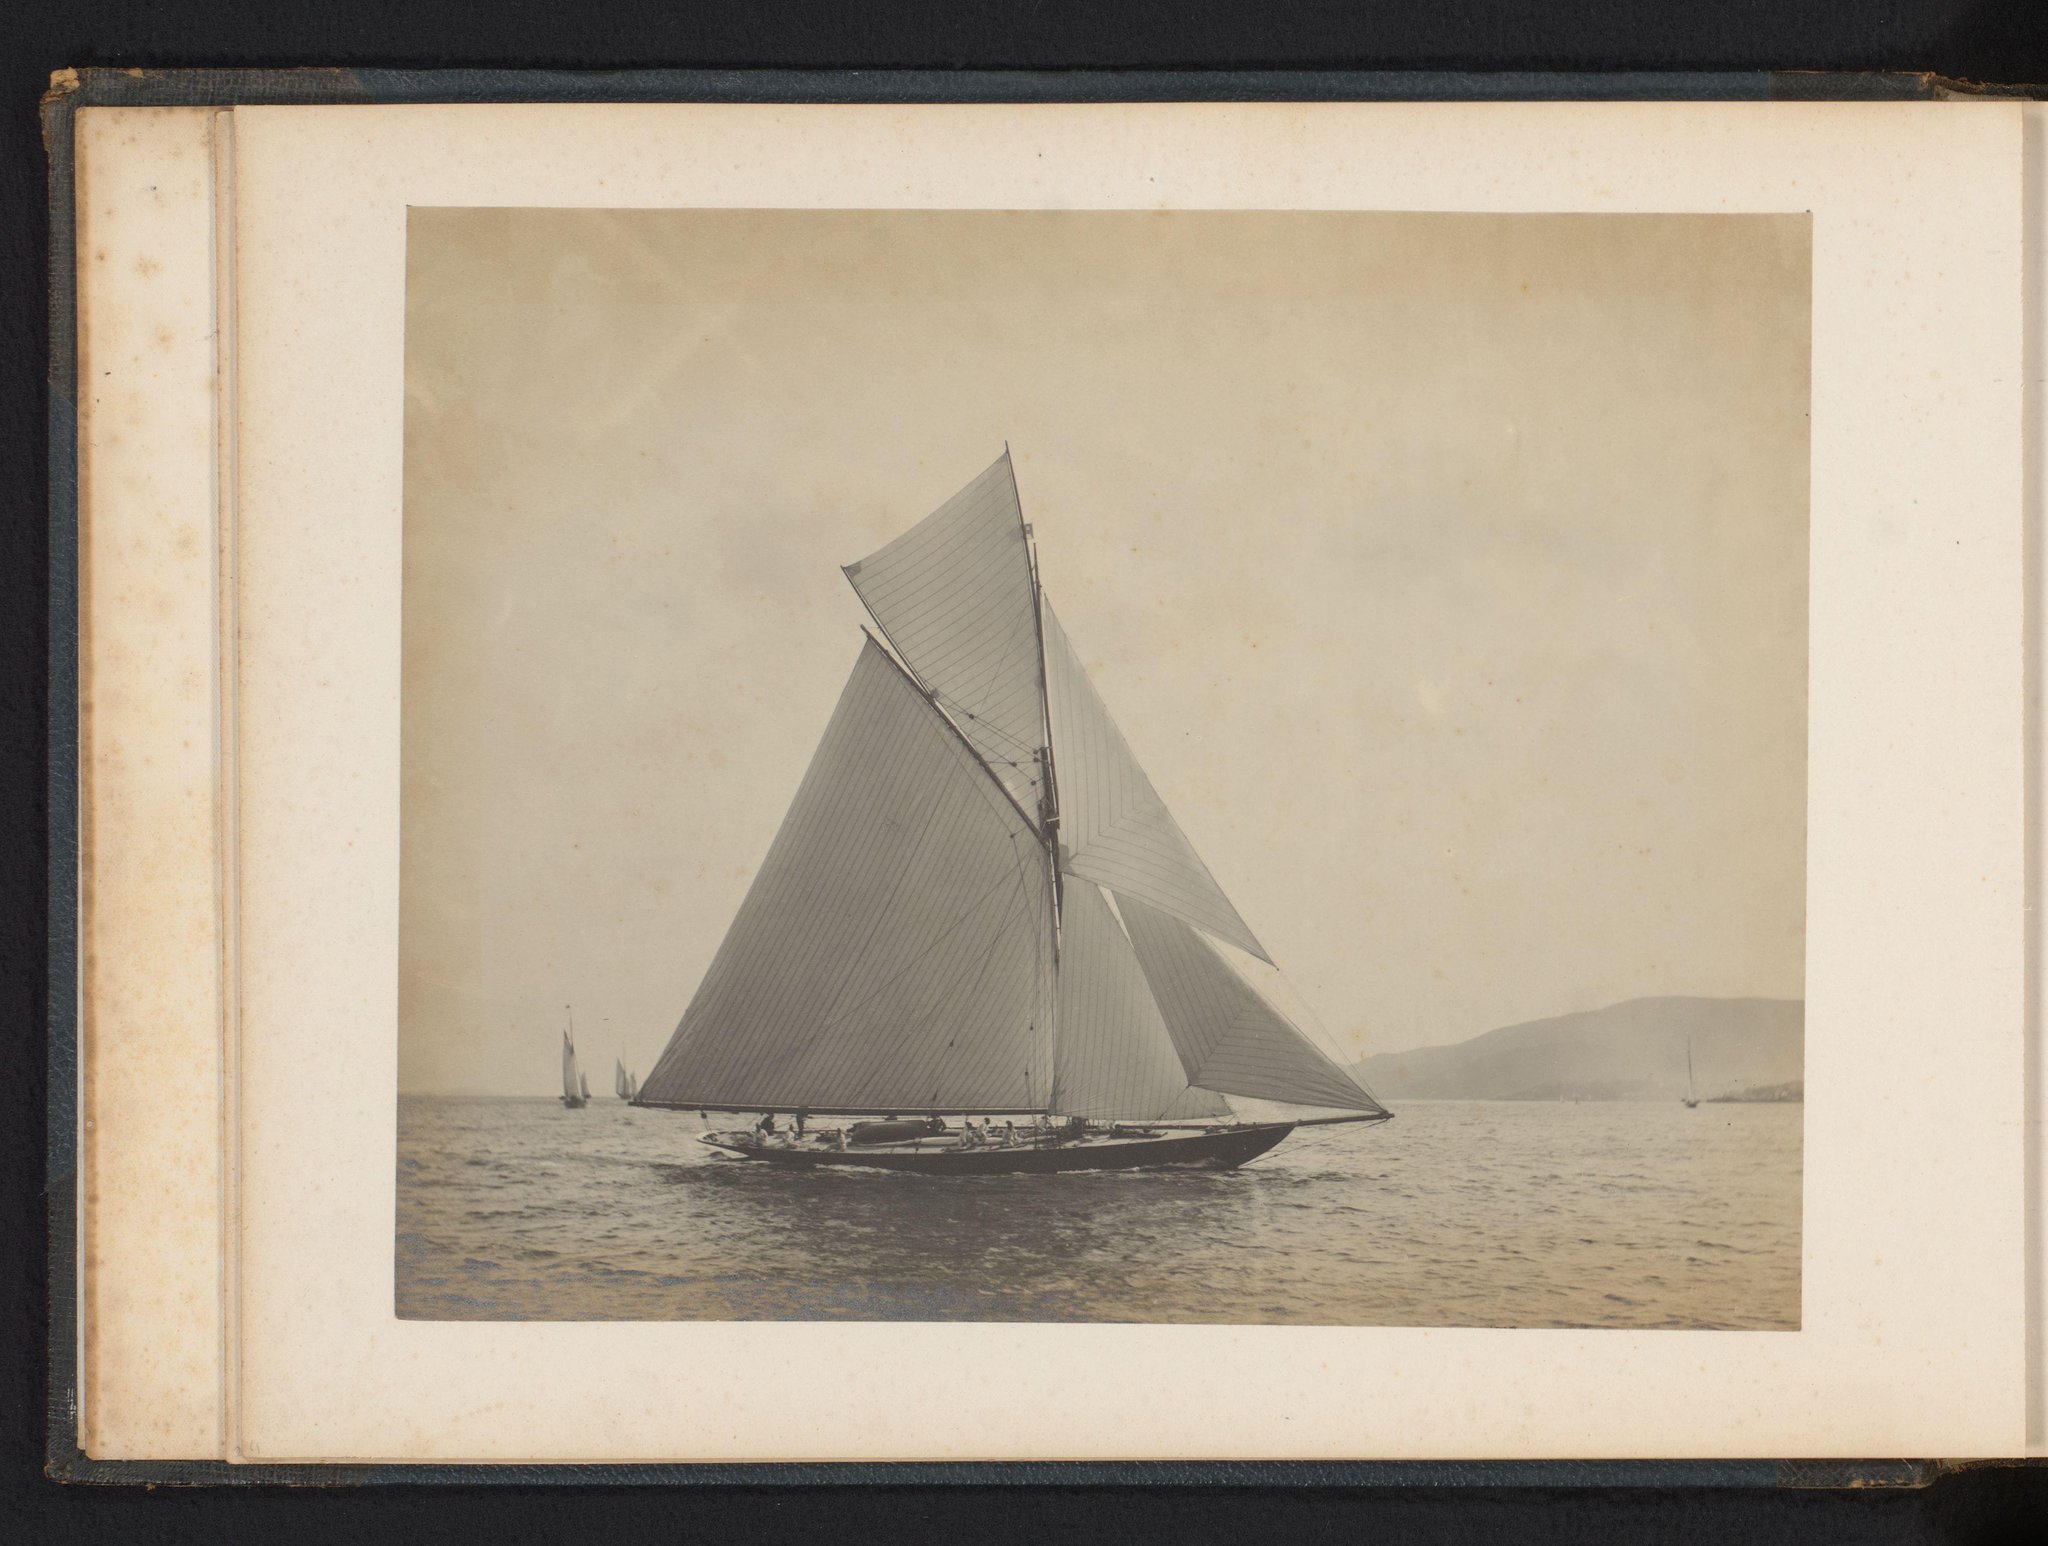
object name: photograph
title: Zeilschip de Queen te water met op de achtergrond andere zeilschepen en een heuvel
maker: james adamson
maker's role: fotograaf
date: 1880-1900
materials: photographic support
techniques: gelatin silver print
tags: sailing-ship, sailing-boat, landscapes with waters, waterscapes, seascapes (in the temperate zone), (high) hill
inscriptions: check stamp: ‘Adamson, Rothesay.H.B’